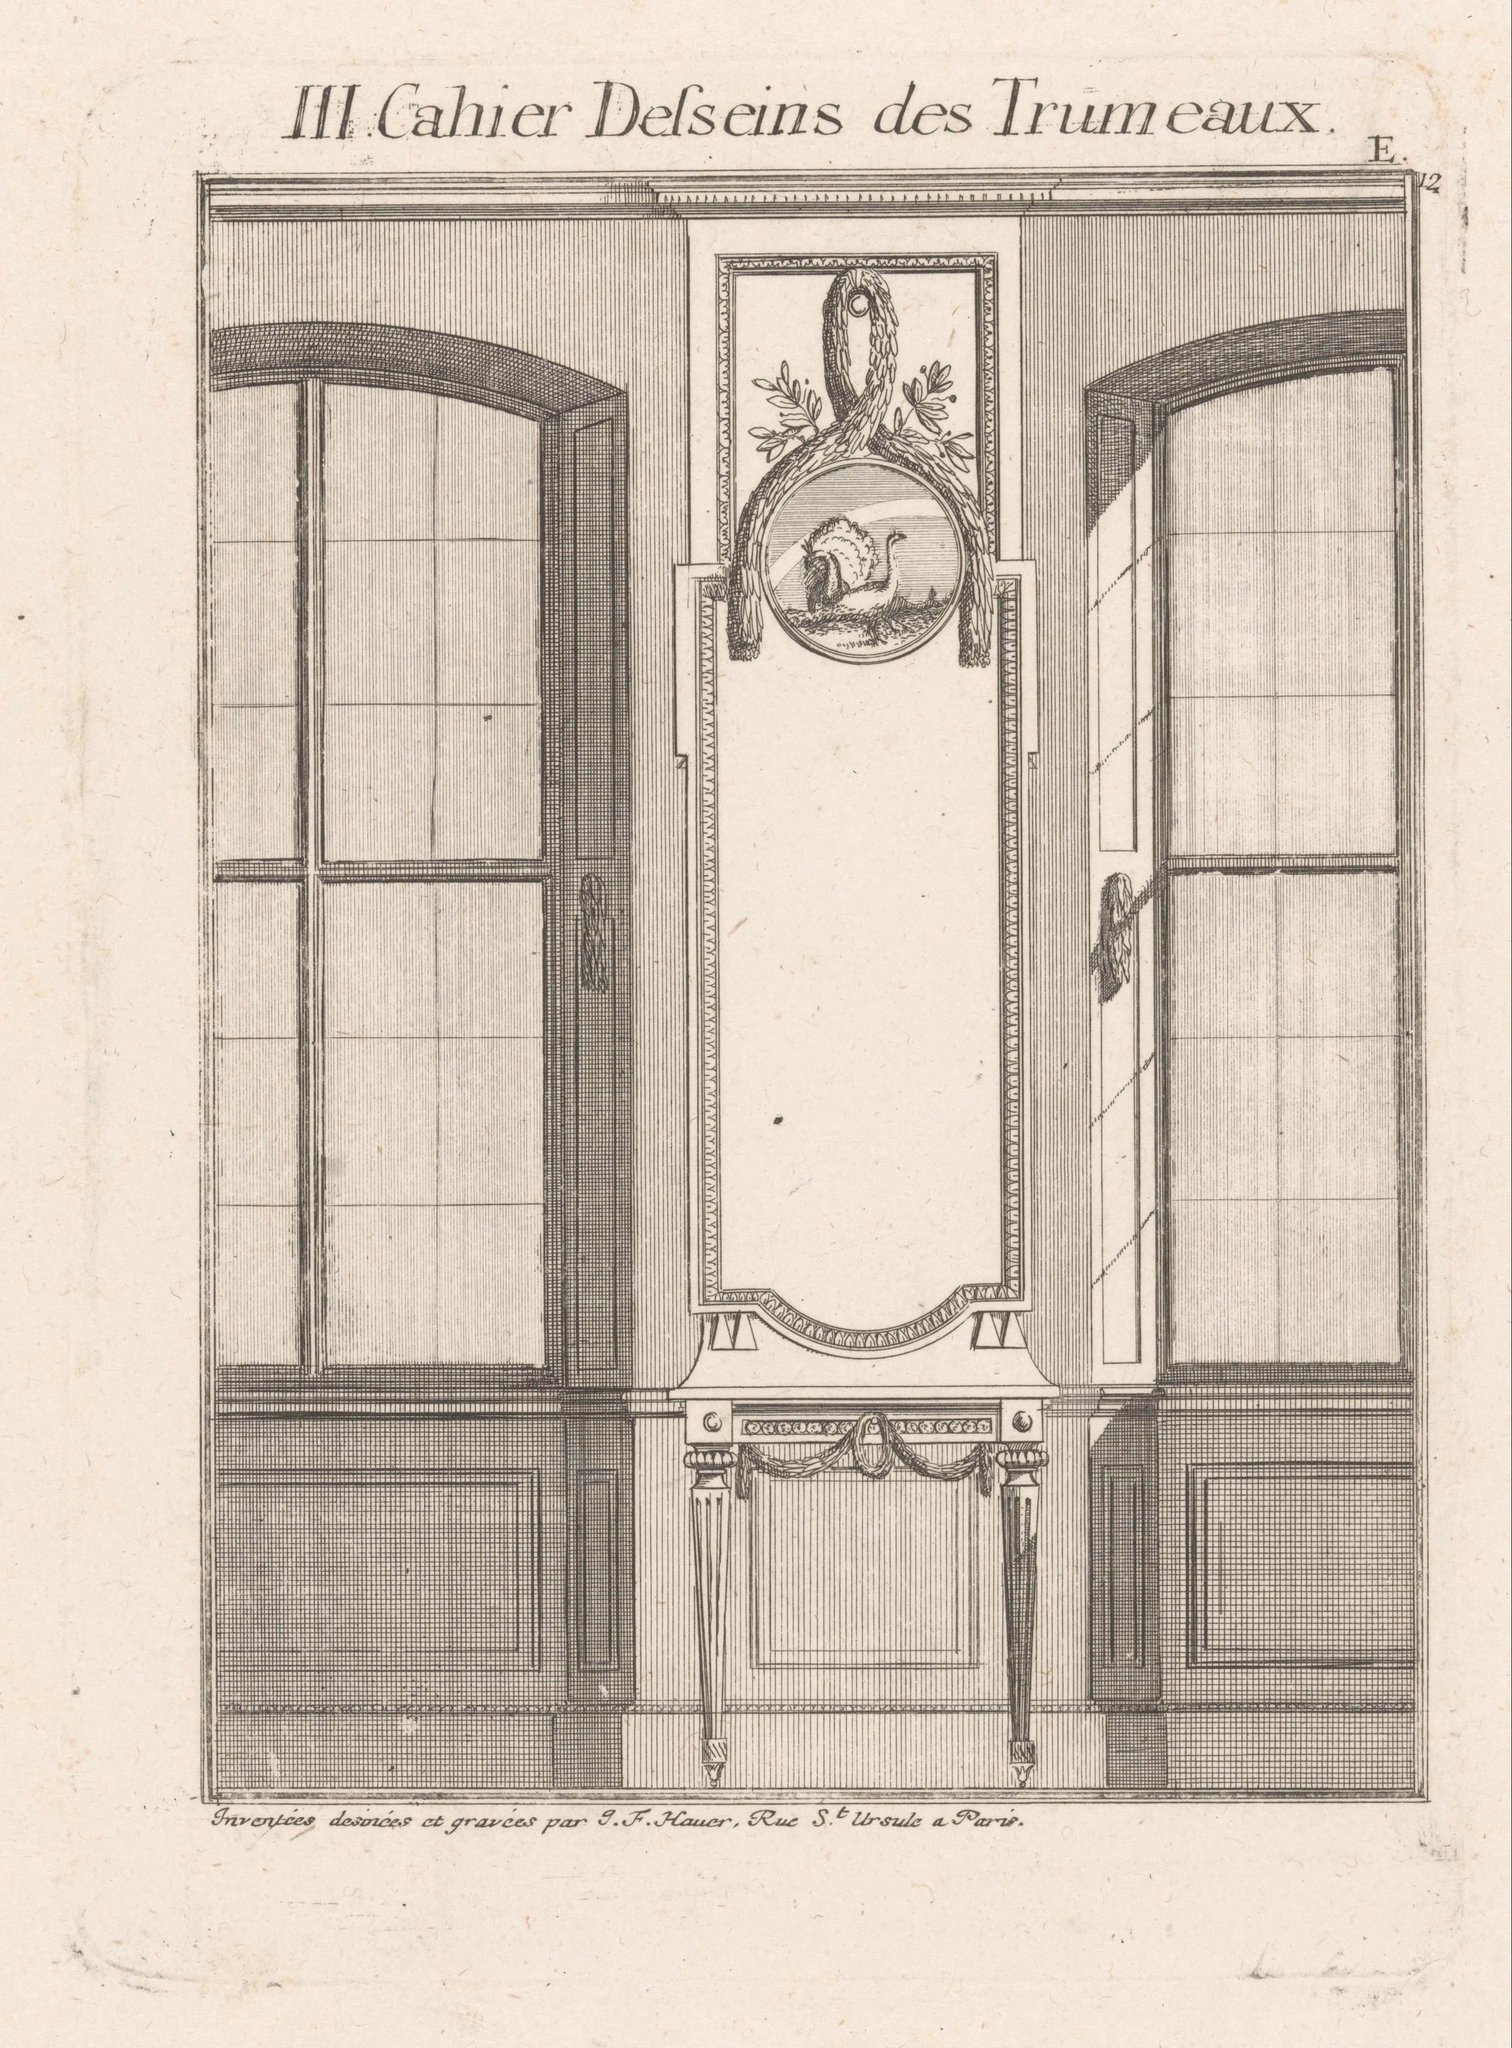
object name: print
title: Desseins de la Mode neuve au Gout antique (...)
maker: johann thomas hauer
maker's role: print maker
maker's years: 1748-1820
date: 1781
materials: paper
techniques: engraving, etching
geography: paris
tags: half-column, pilaster ~ architecture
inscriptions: collector's mark: Lugt 2760, collector's mark: Lugt 2228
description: Ontwerp voor een trumeau tussen twee ramen. Met laurierguirlande en medaillon met pauwen.